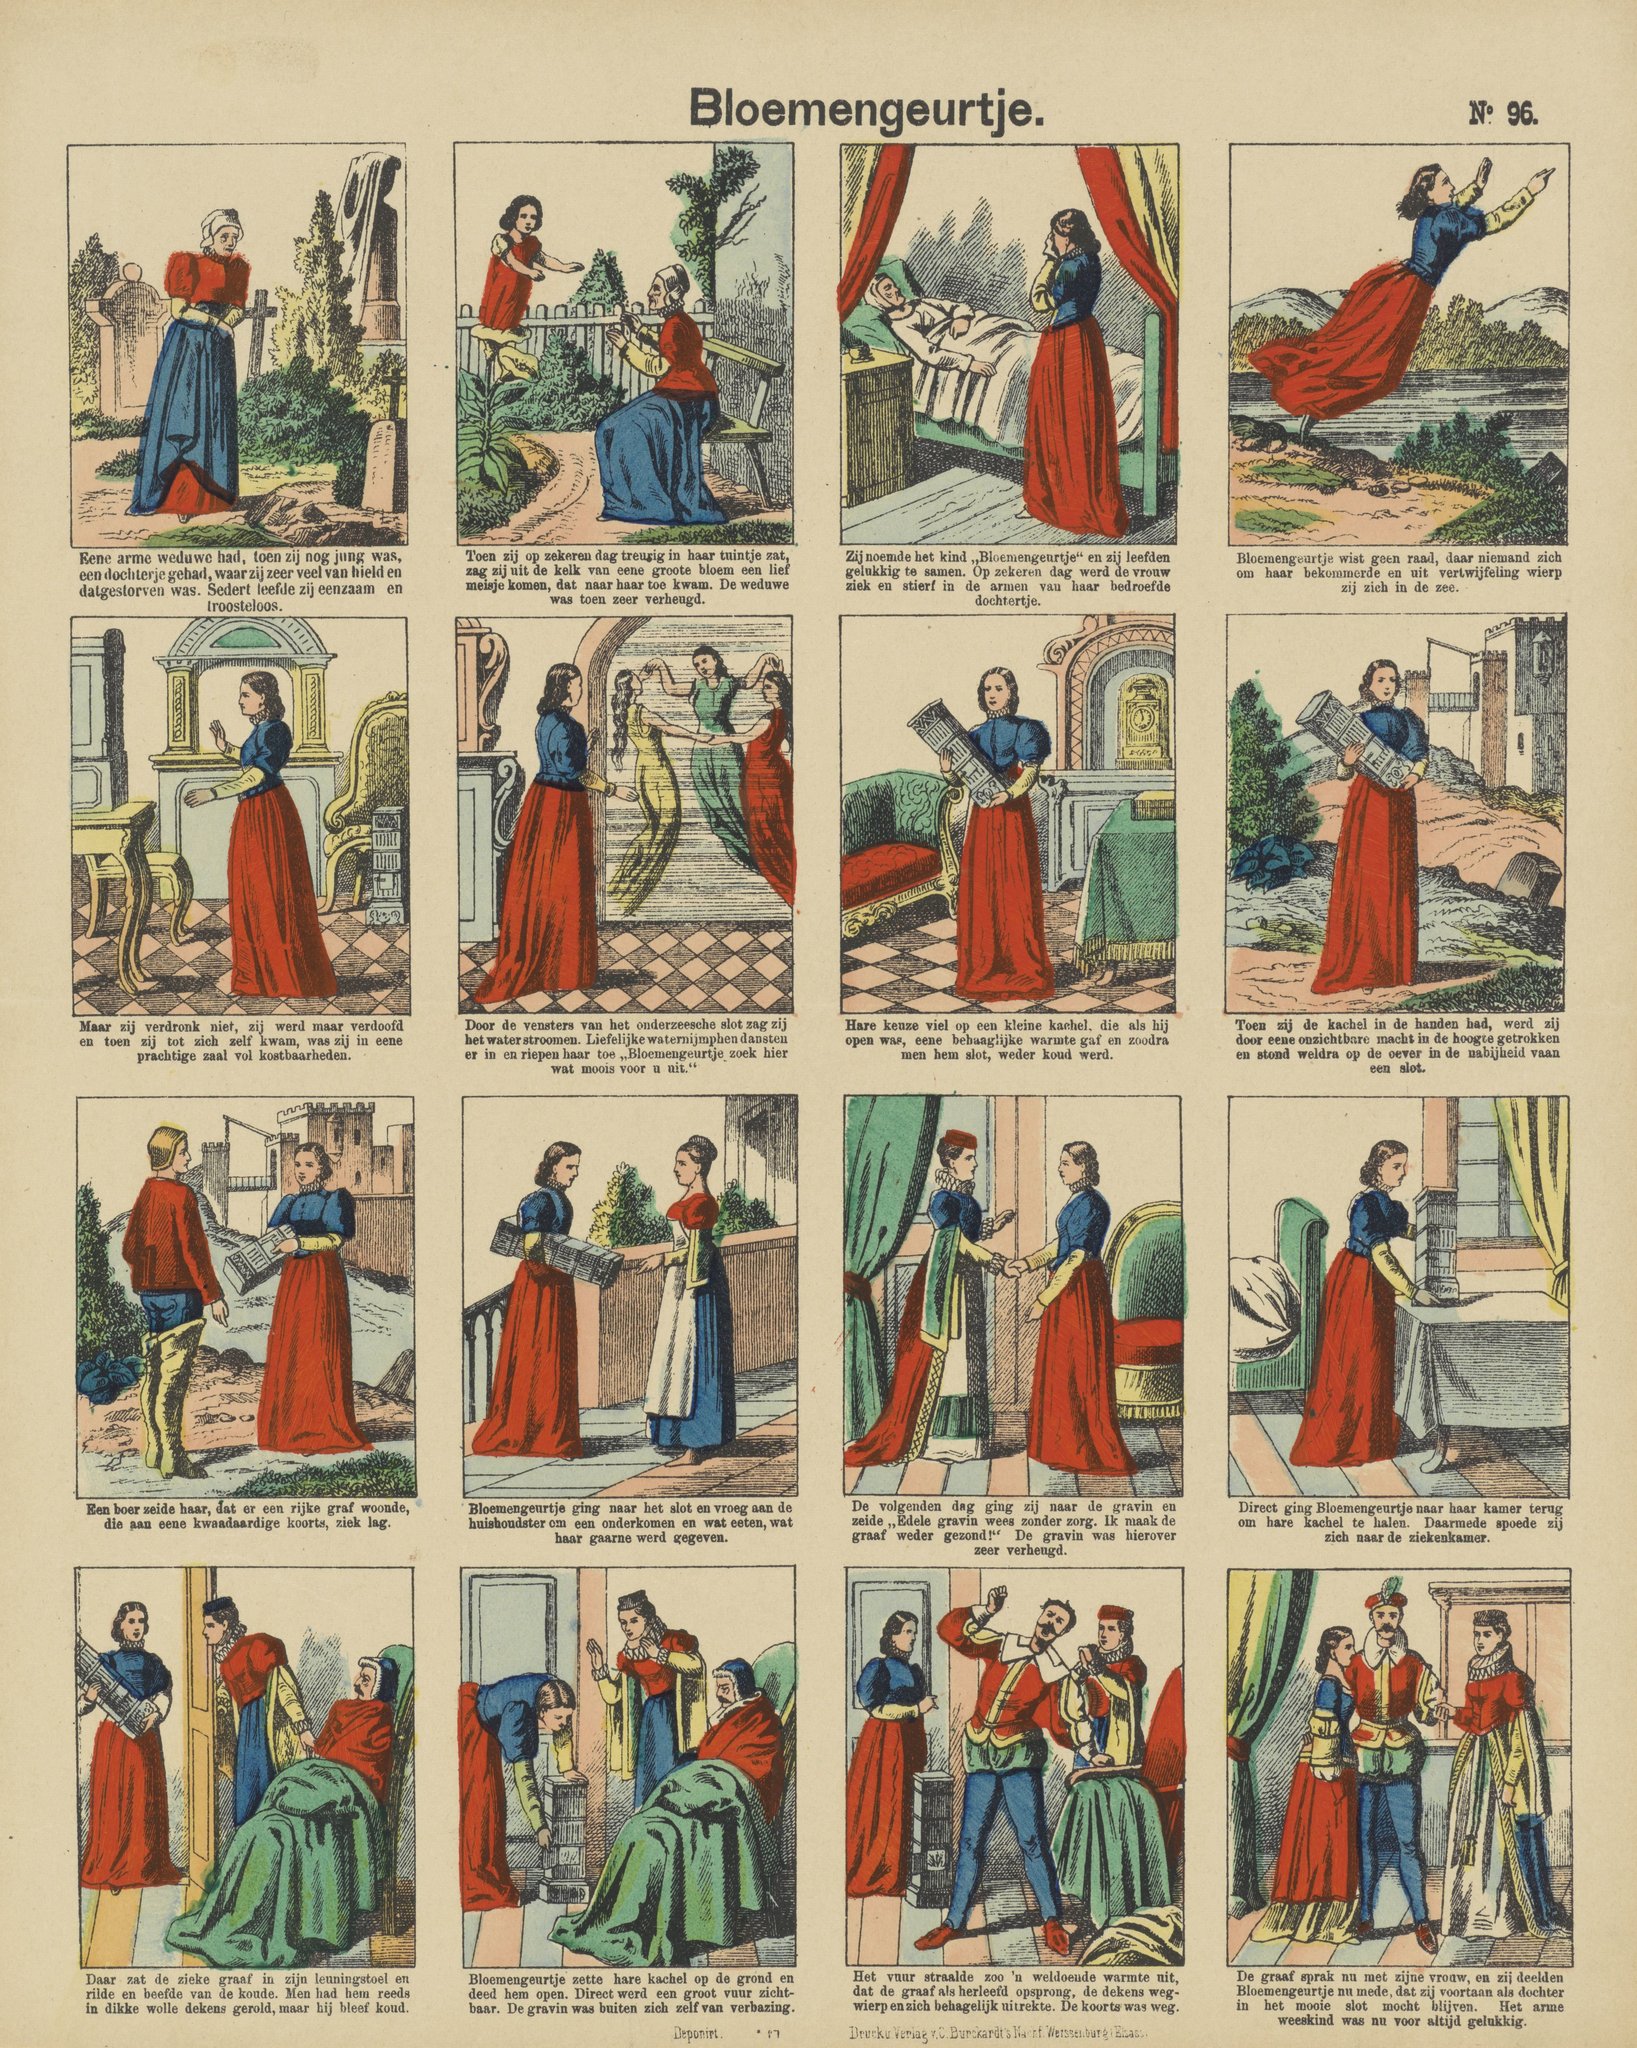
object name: print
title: Bloemengeurtje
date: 1889-1906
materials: paper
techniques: hand coloring, letterpress printing, lithograph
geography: wissembourg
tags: tales and fairy tales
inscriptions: collector's mark: Lugt 2760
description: Blad met 16 voorstellingen uit het sprookje van Bloemengeurtje. Onder elke afbeelding een onderschrift. Genummerd rechtsboven: No. 96.